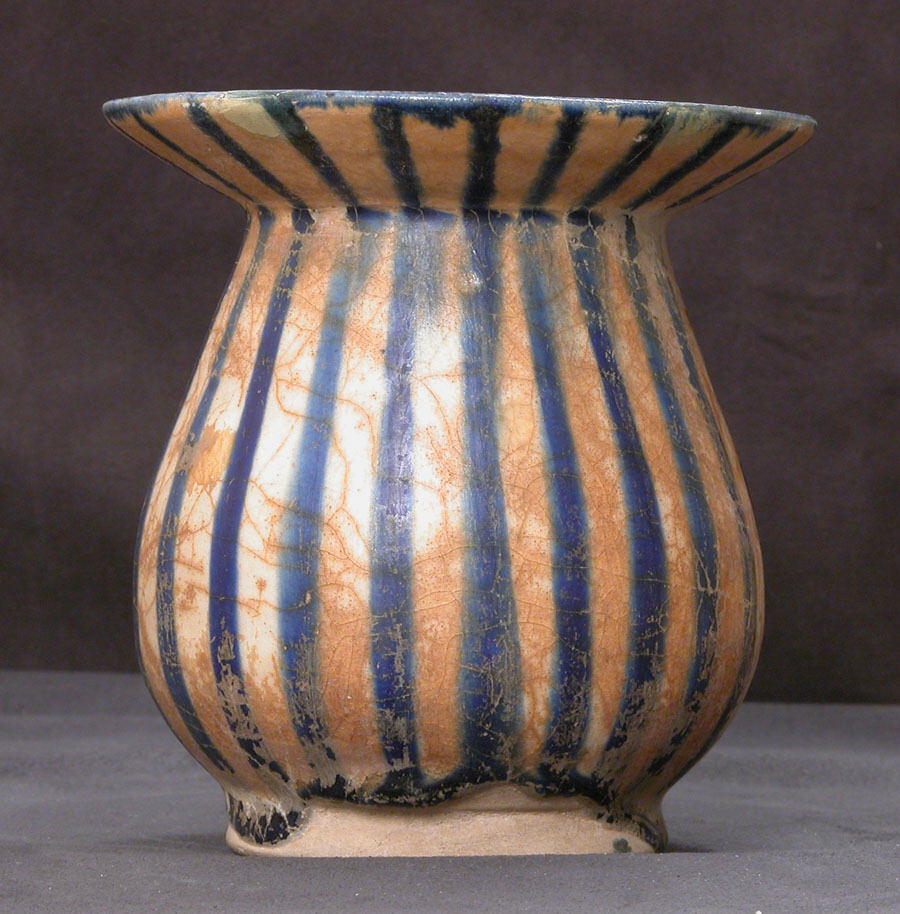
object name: vase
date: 1201-1300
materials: stonepaste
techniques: painting, underglaze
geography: iran